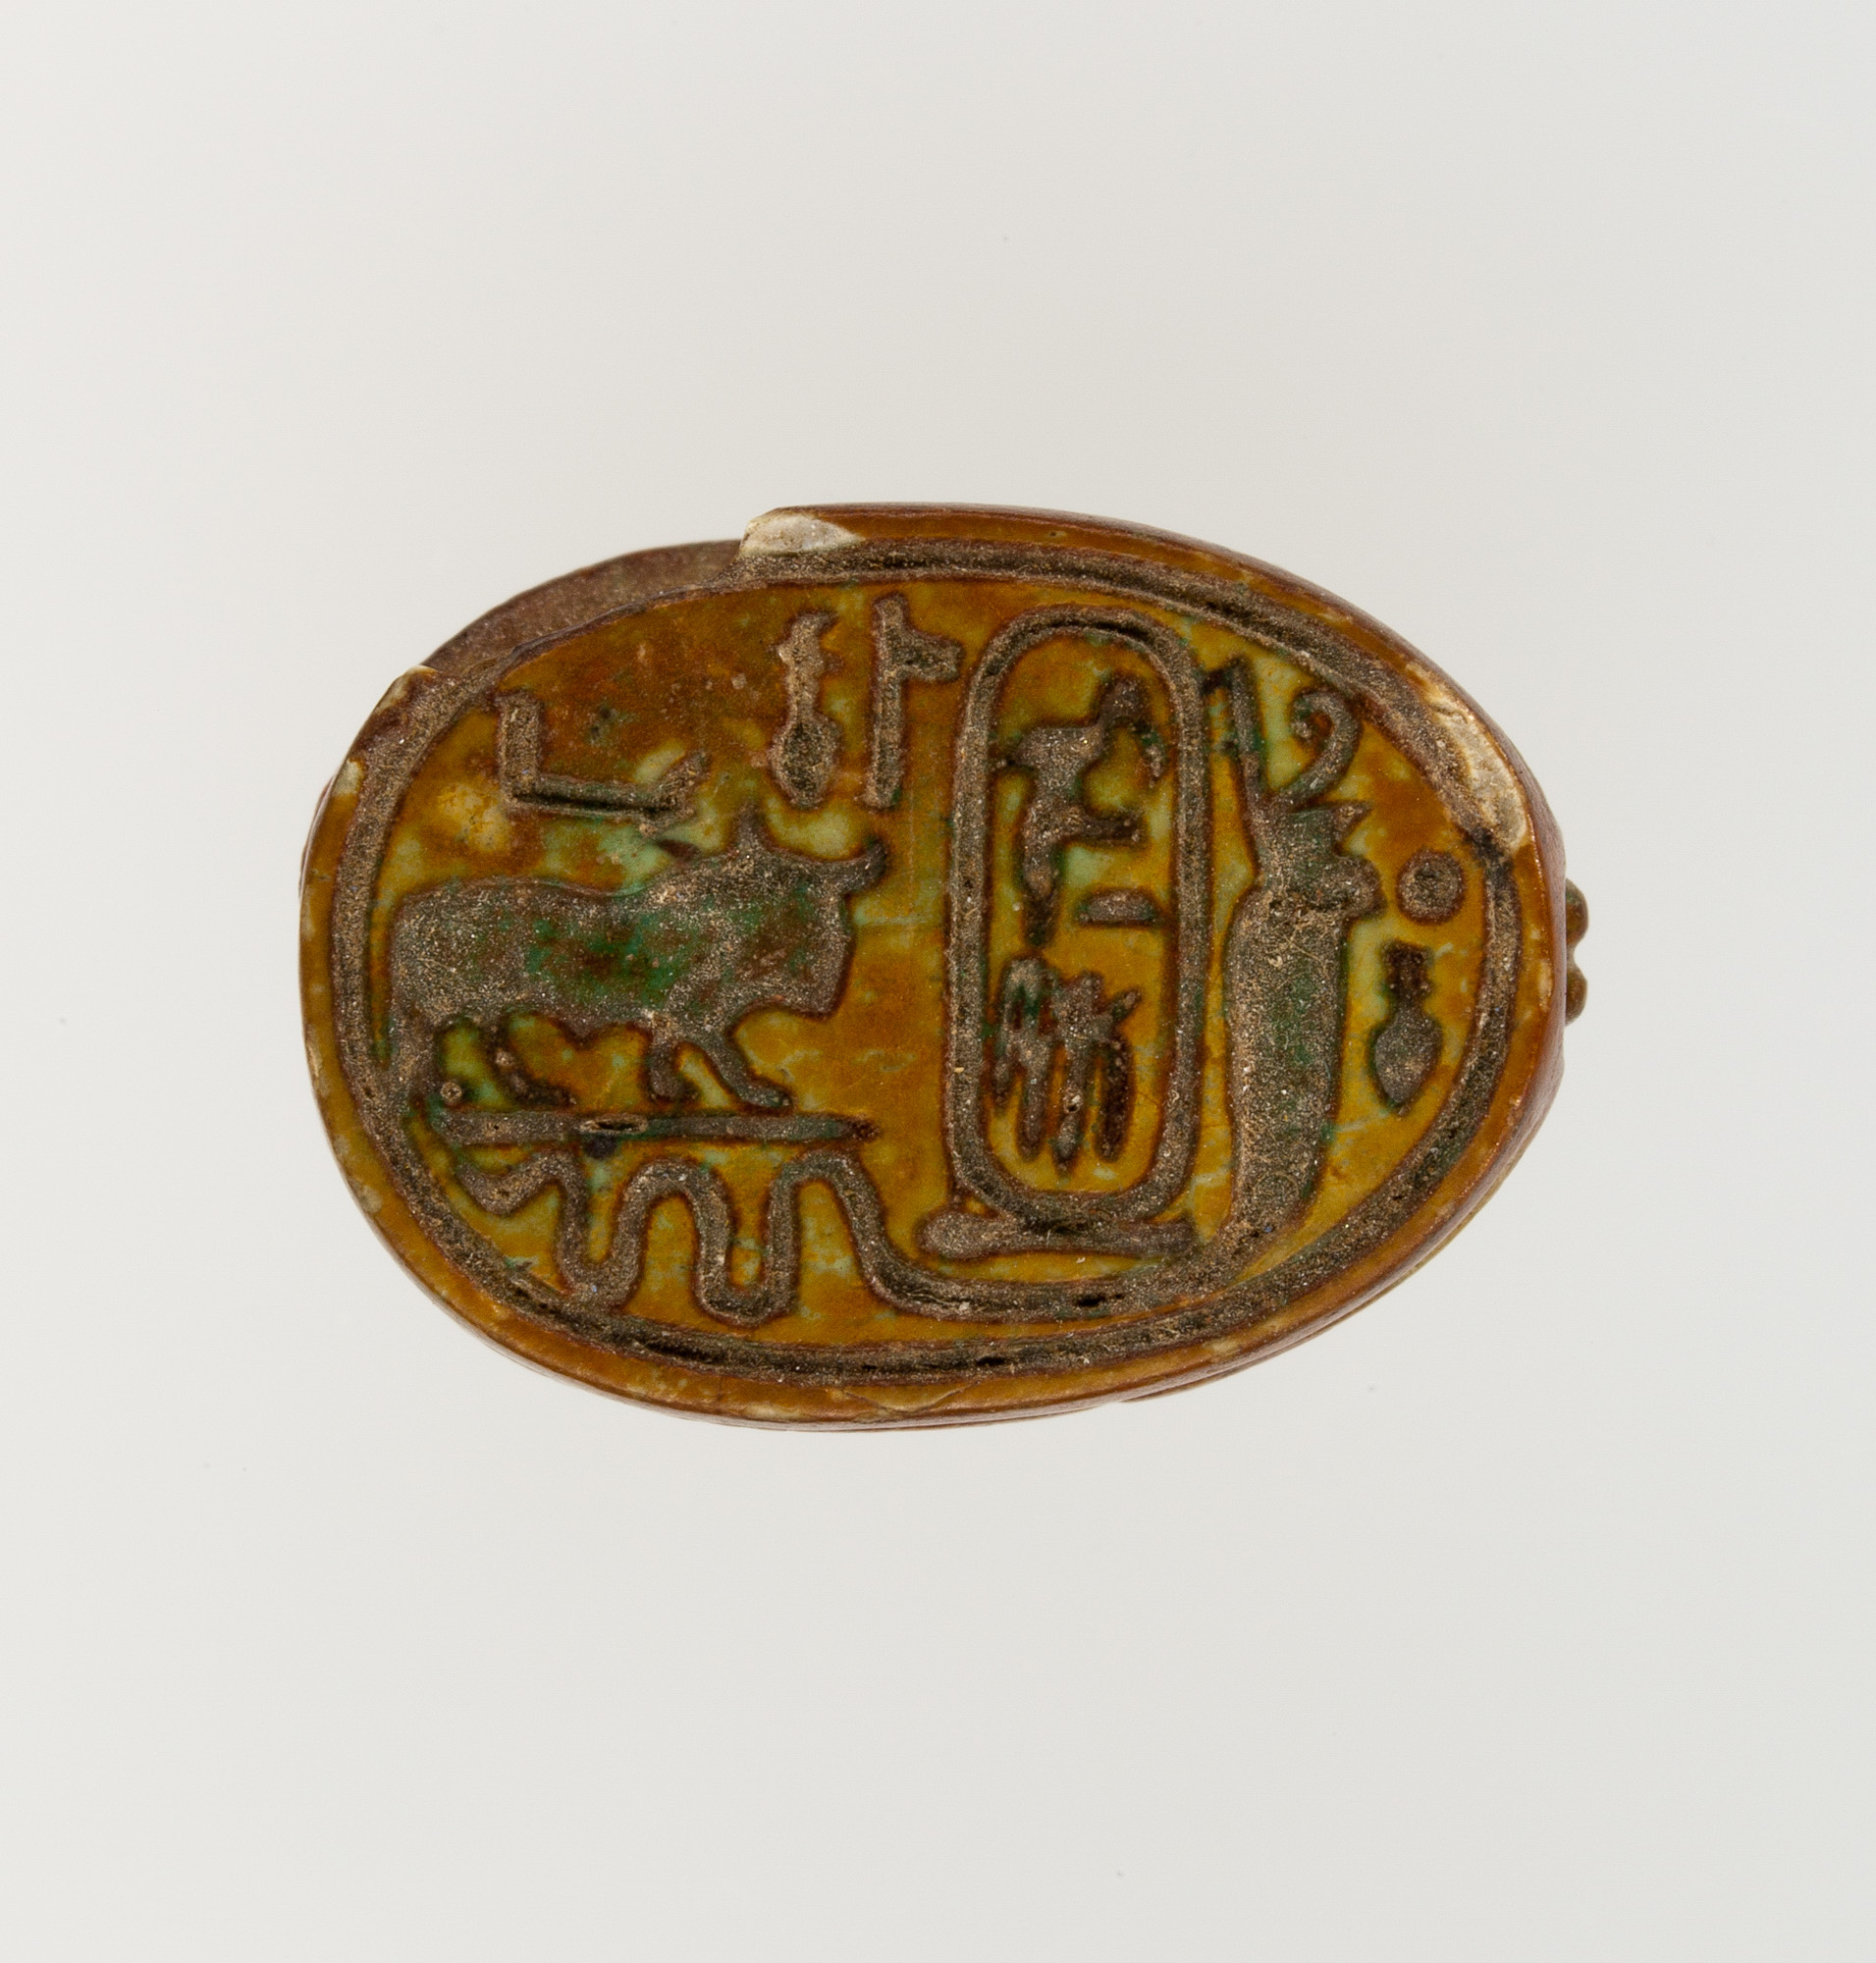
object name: scarab, thutmose i, bull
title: Scarab Inscribed for Thutmose I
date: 1504-1492 BCE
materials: stone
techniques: glazing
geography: egypt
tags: hieroglyphs,scarabs